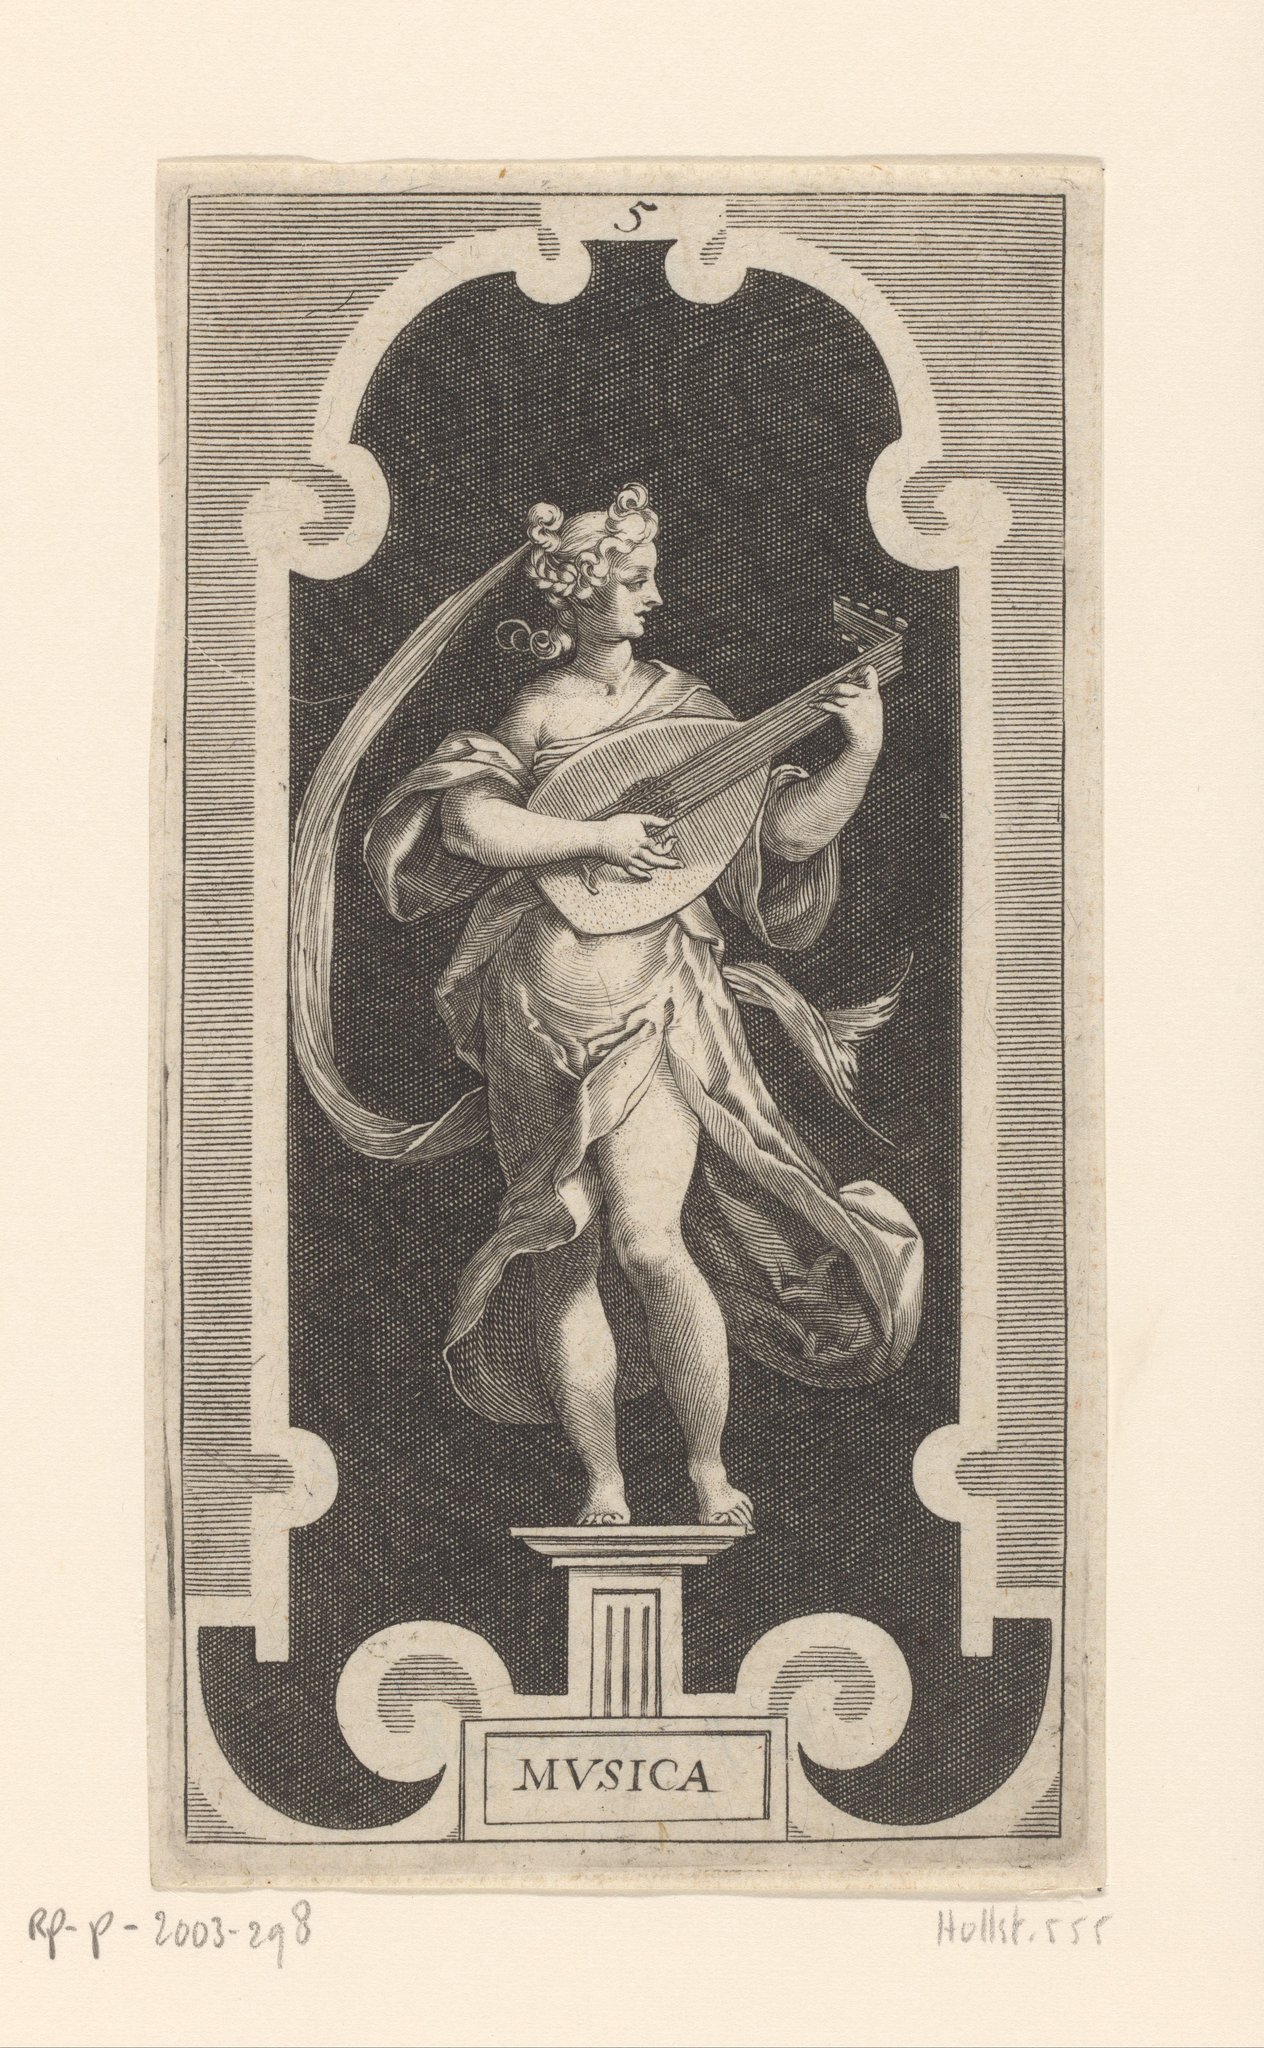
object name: print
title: Zeven Vrij Kunsten in beeld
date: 1640-1708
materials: paper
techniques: engraving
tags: the liberal arts, 'artes liberales', 'musica' (~ quadrivium); 'musica' (ripa), lute, and special forms of lute, e.g.: theorbo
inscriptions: collector's mark: Lugt 2760, collector's mark: Lugt 2228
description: Deze prent hoort bij een serie van zeven prenten met personificaties van Zeven Vrij Kunsten.